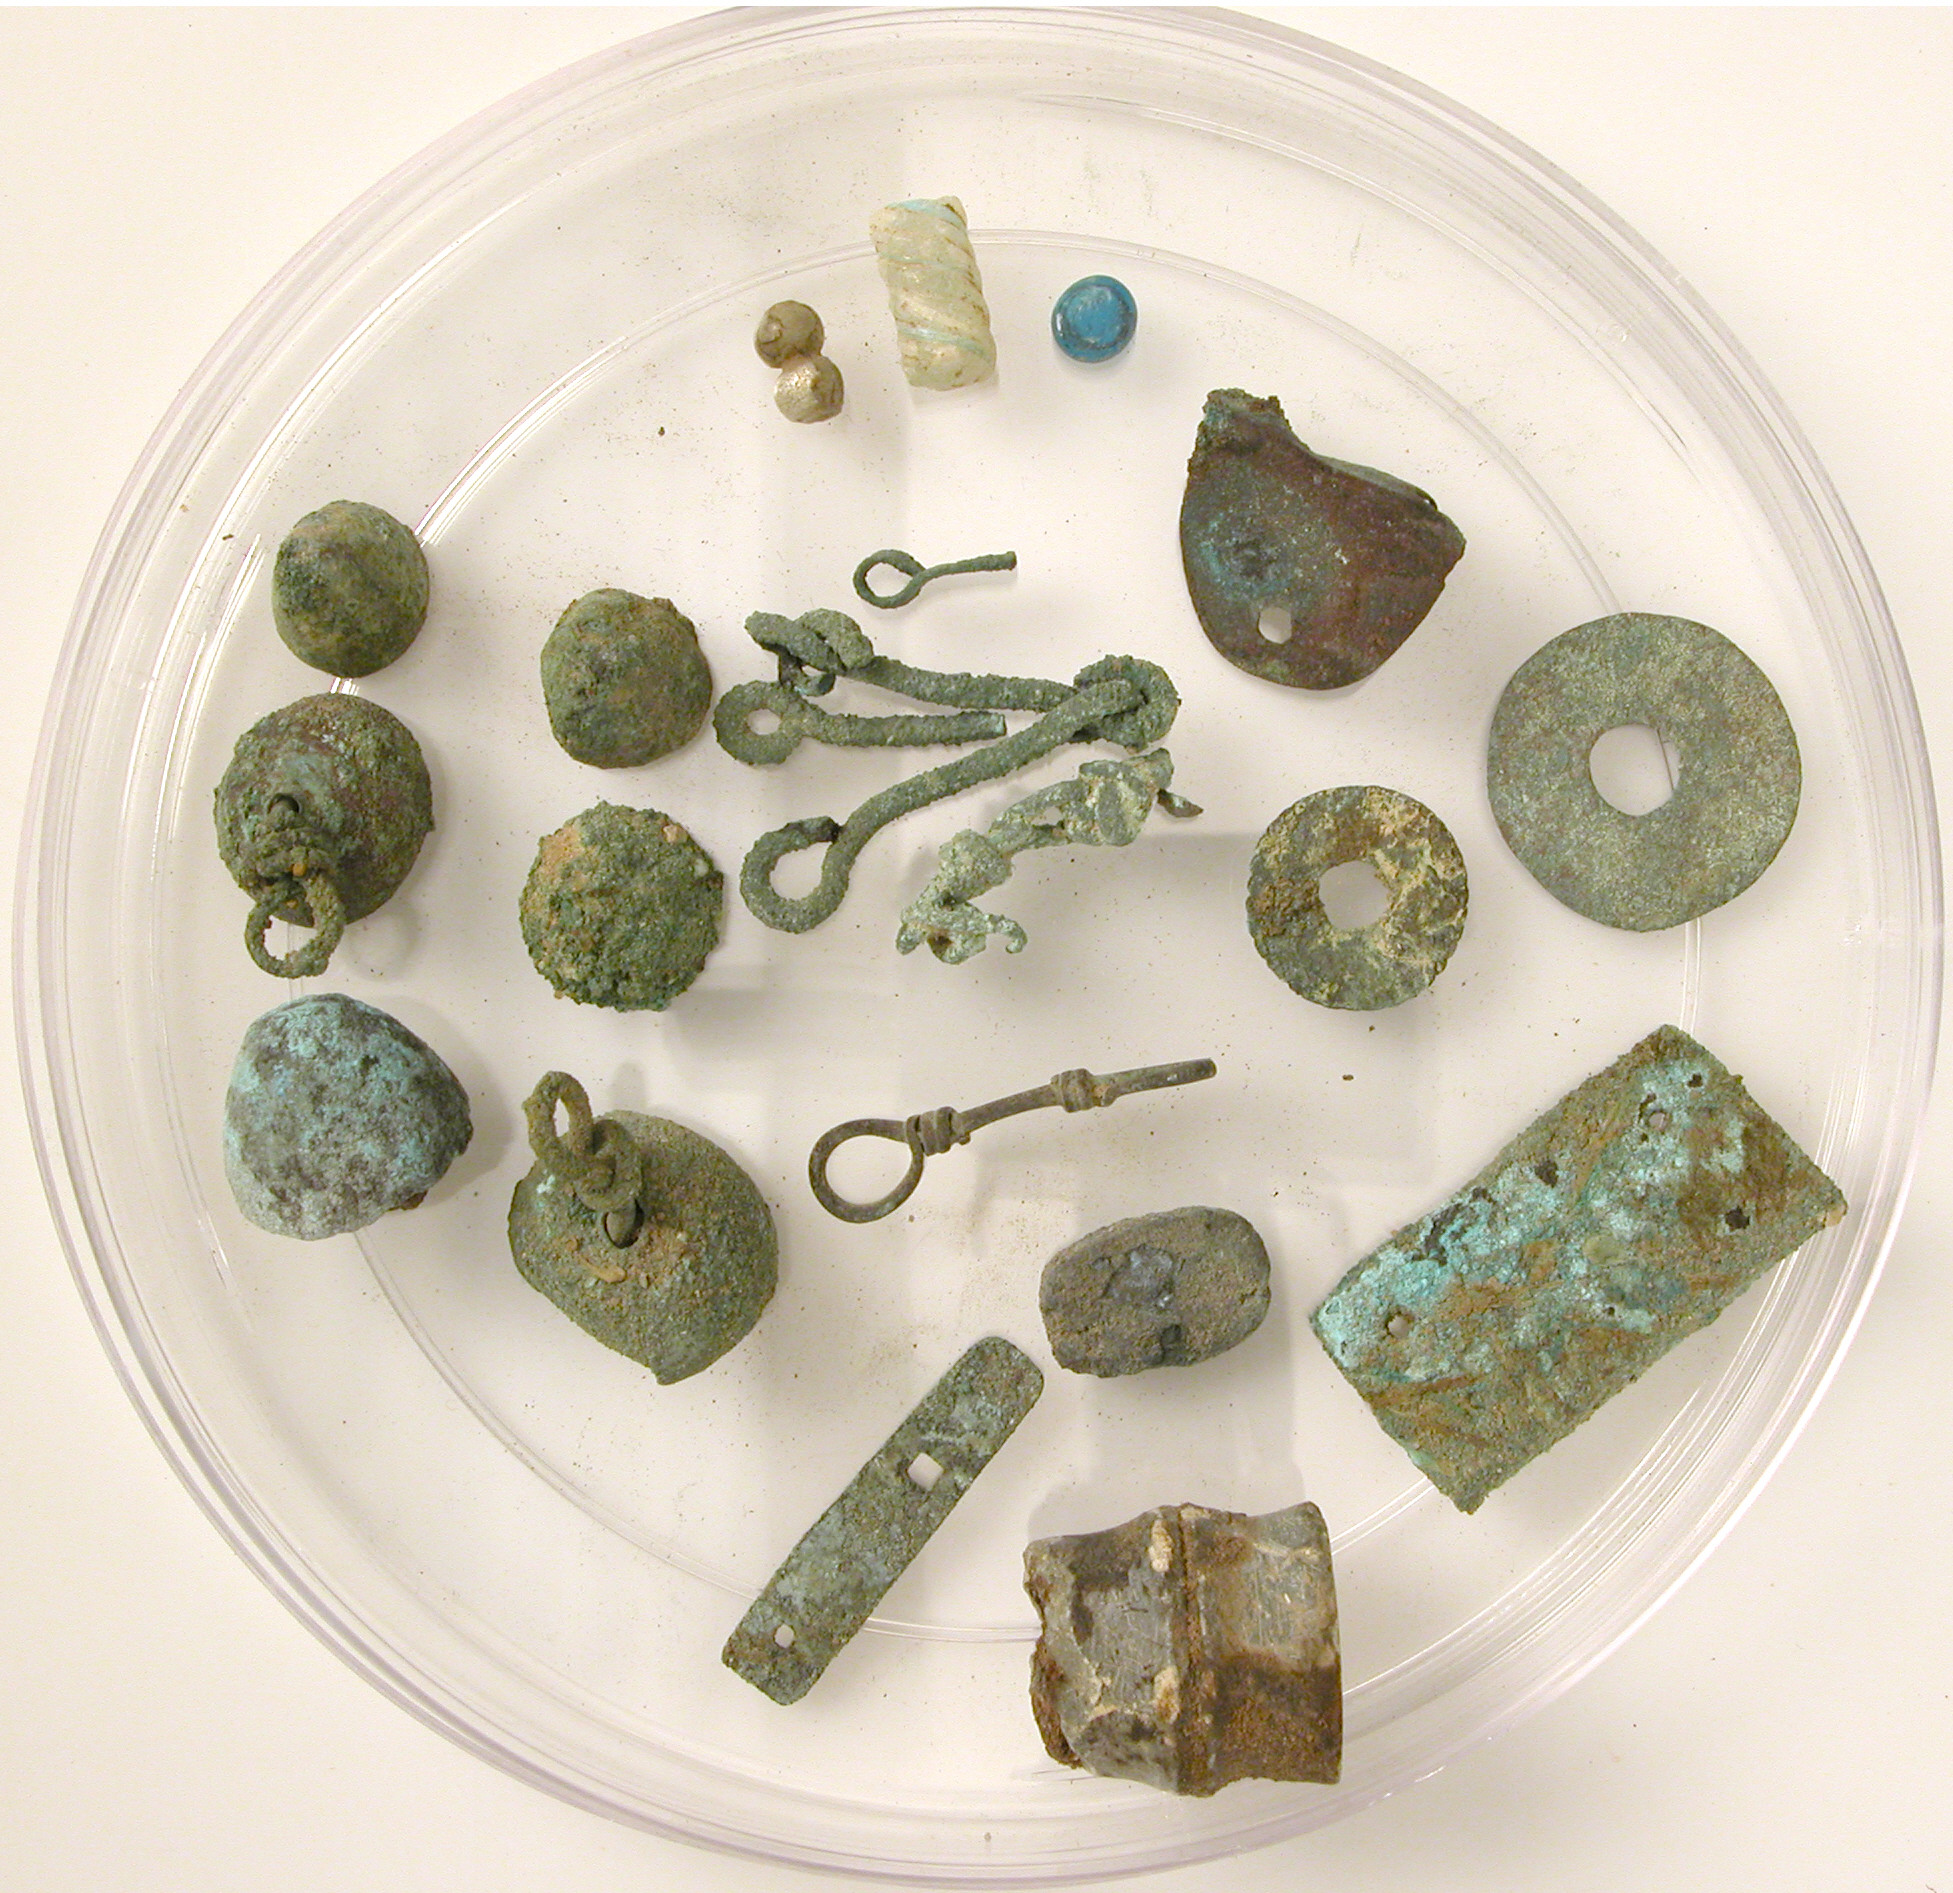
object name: fragment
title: Fragments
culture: coptic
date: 301-700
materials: copper alloy, glass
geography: egypt